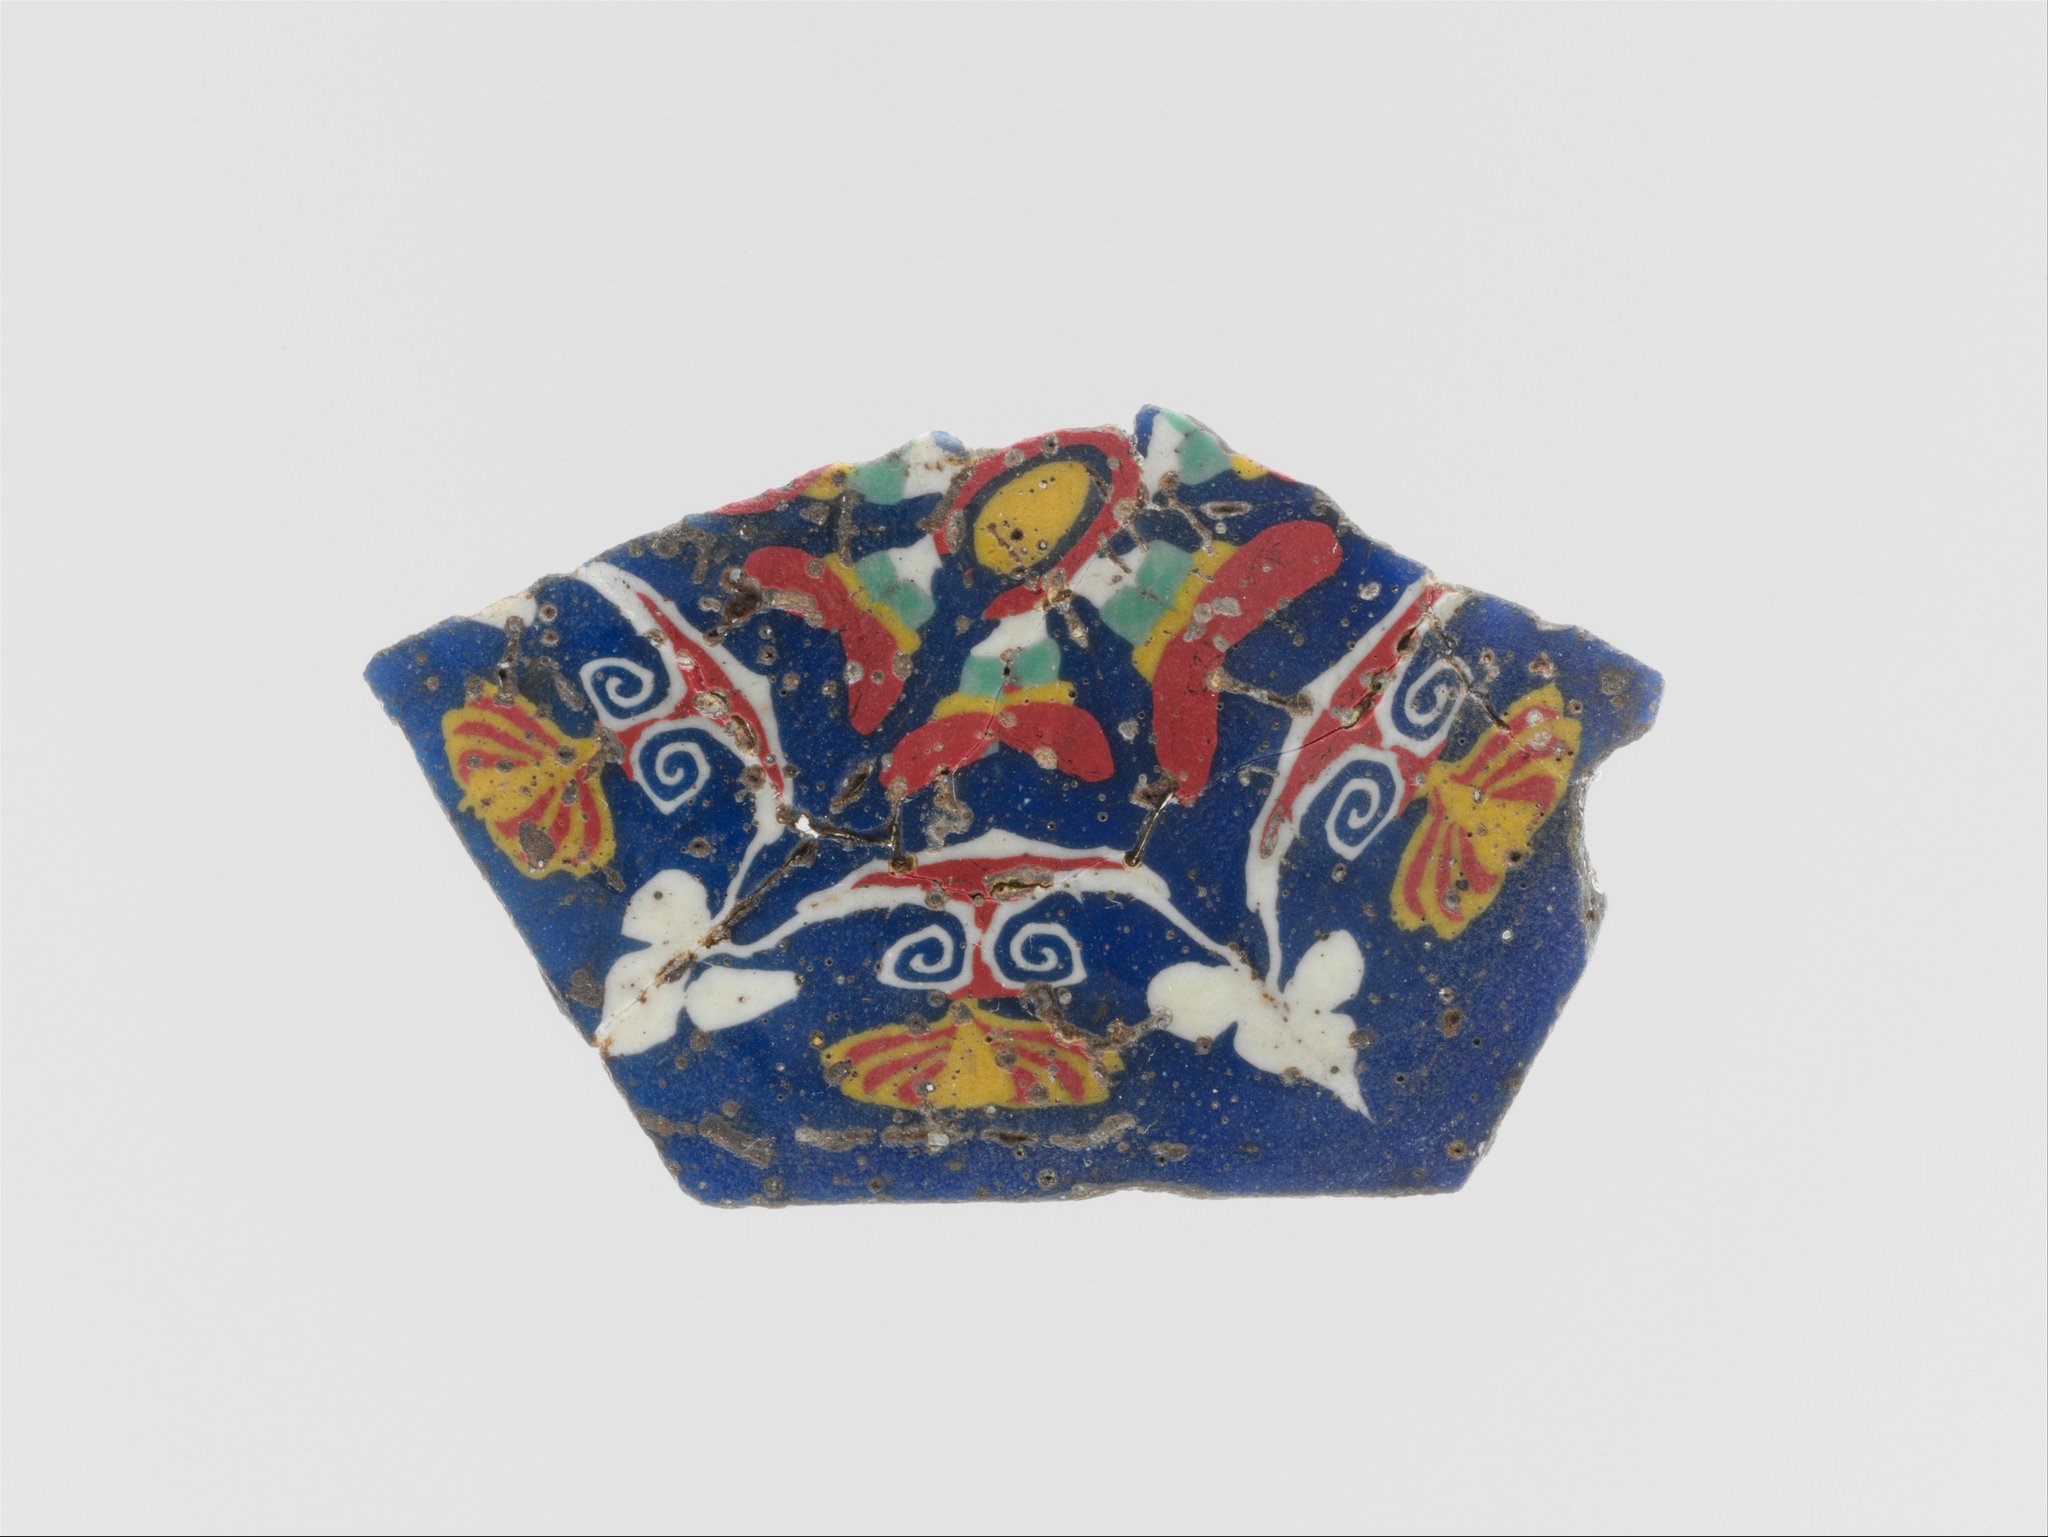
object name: mosaic block inlay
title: Glass mosaic inlay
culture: egyptian or roman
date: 34 BCE-33 CE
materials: glass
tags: leaves